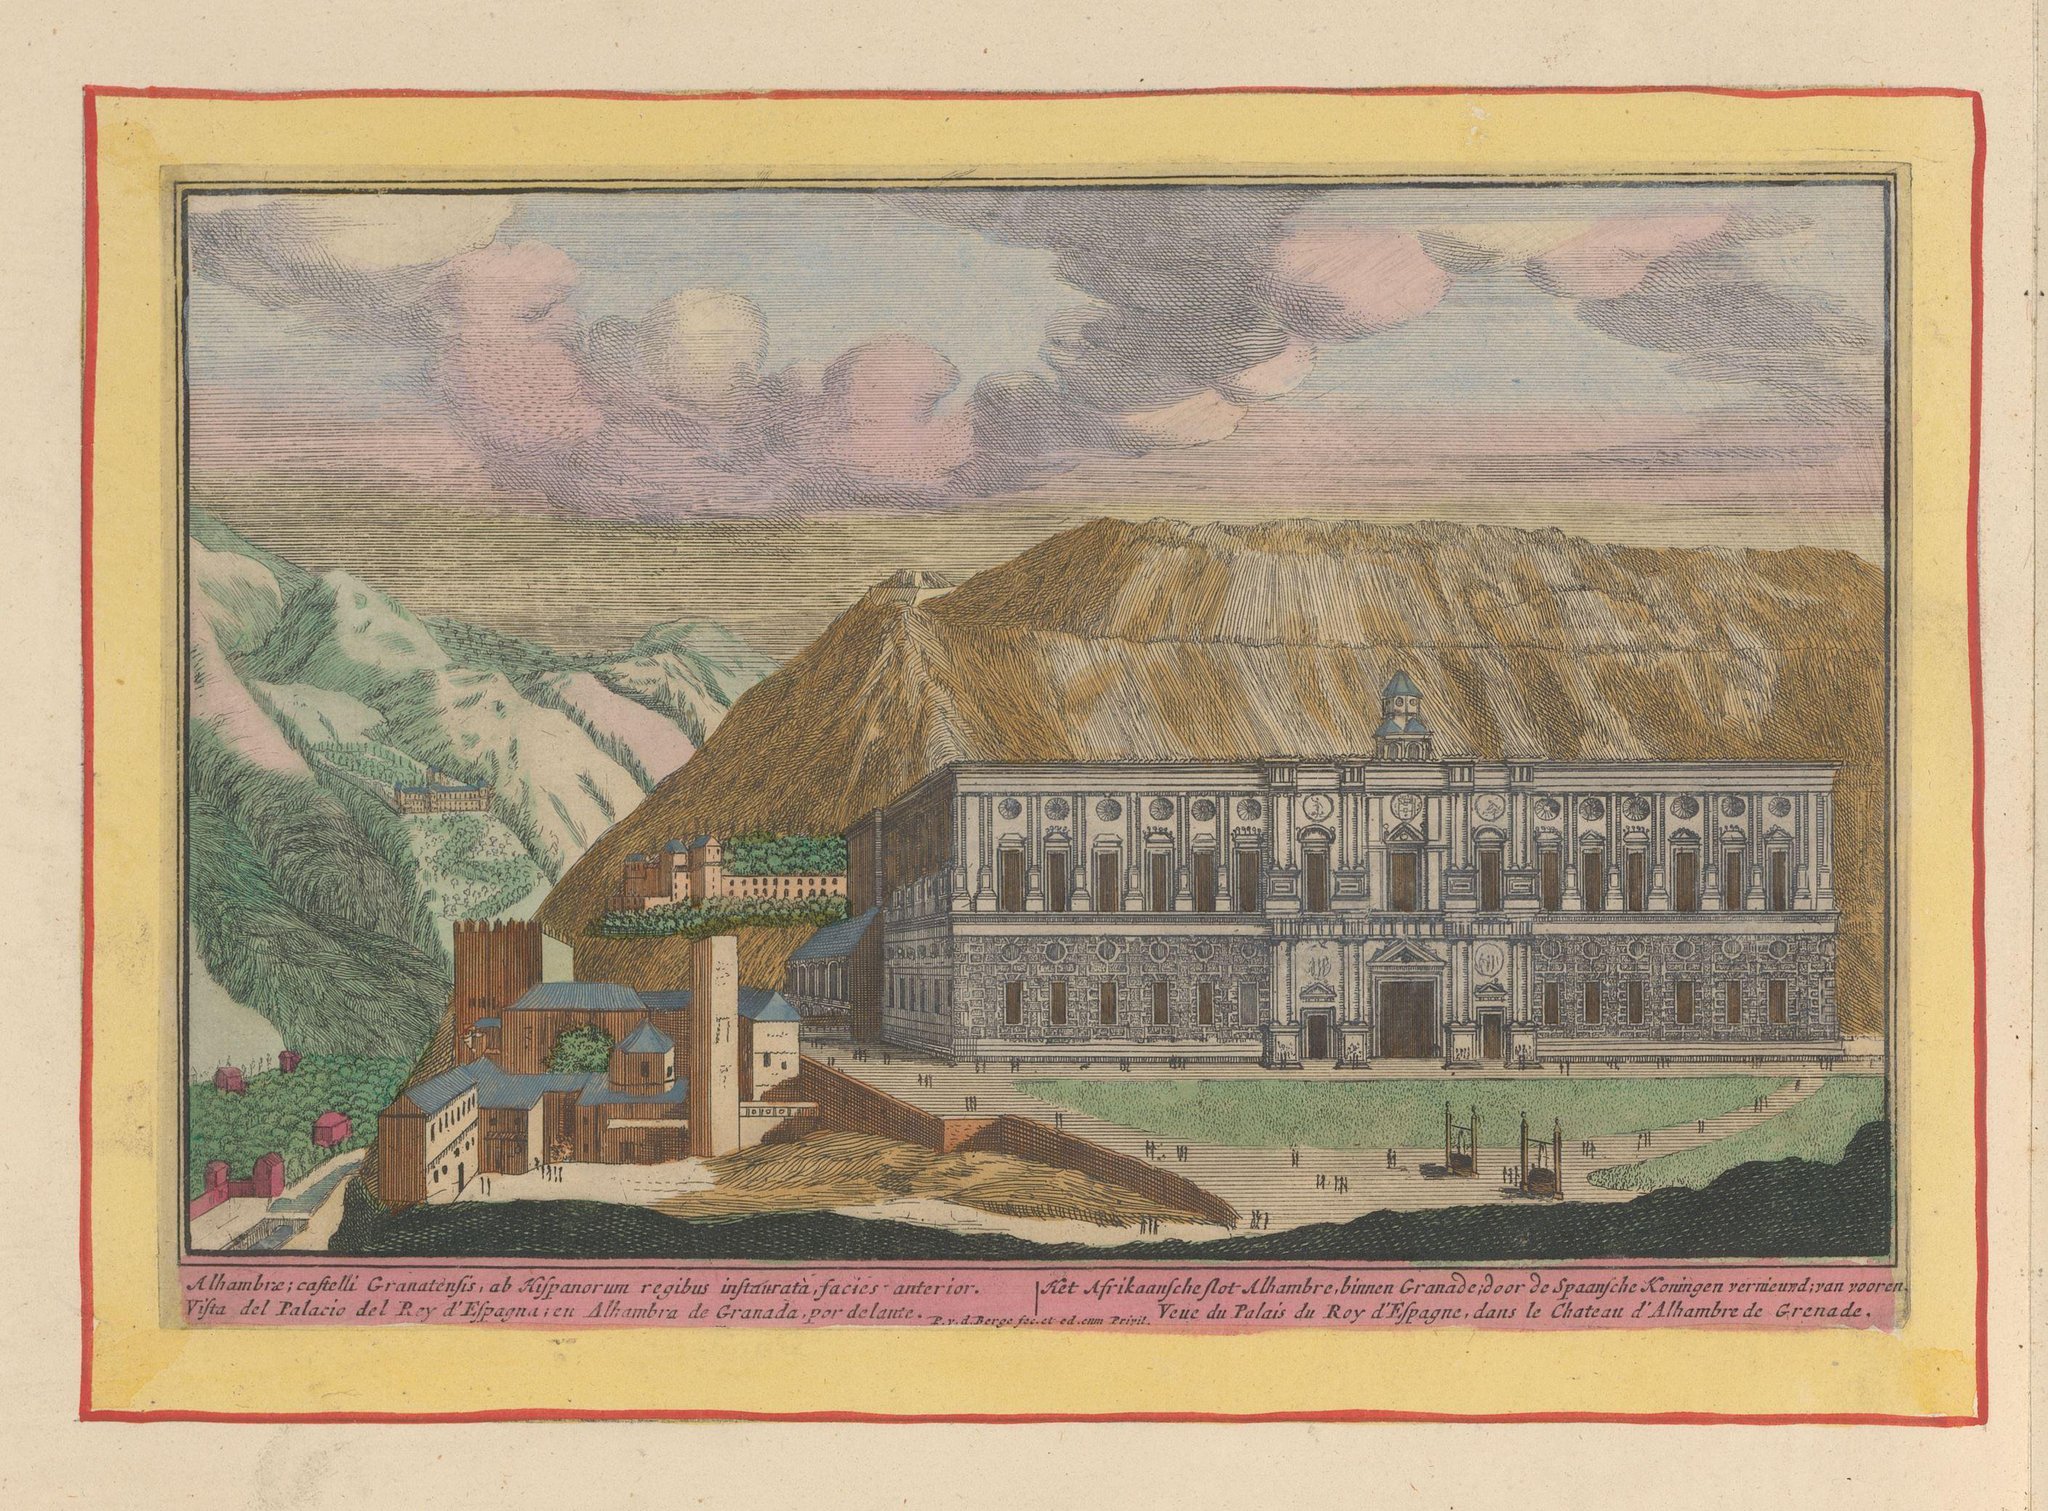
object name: print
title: Gezicht op het Paleis van Karel V te Granada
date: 1694-1737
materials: paper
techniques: etching, hand coloring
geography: amsterdam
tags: palace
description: Prent uit: Theatrum Hispaniæ, exhibens regni urbes, villas ac viridaria magis illustria. Het aanmerkelykste en voortreffelykste in Spanjen (...). Amsterdam: Pieter van den Berge, ca. 1694-1737.